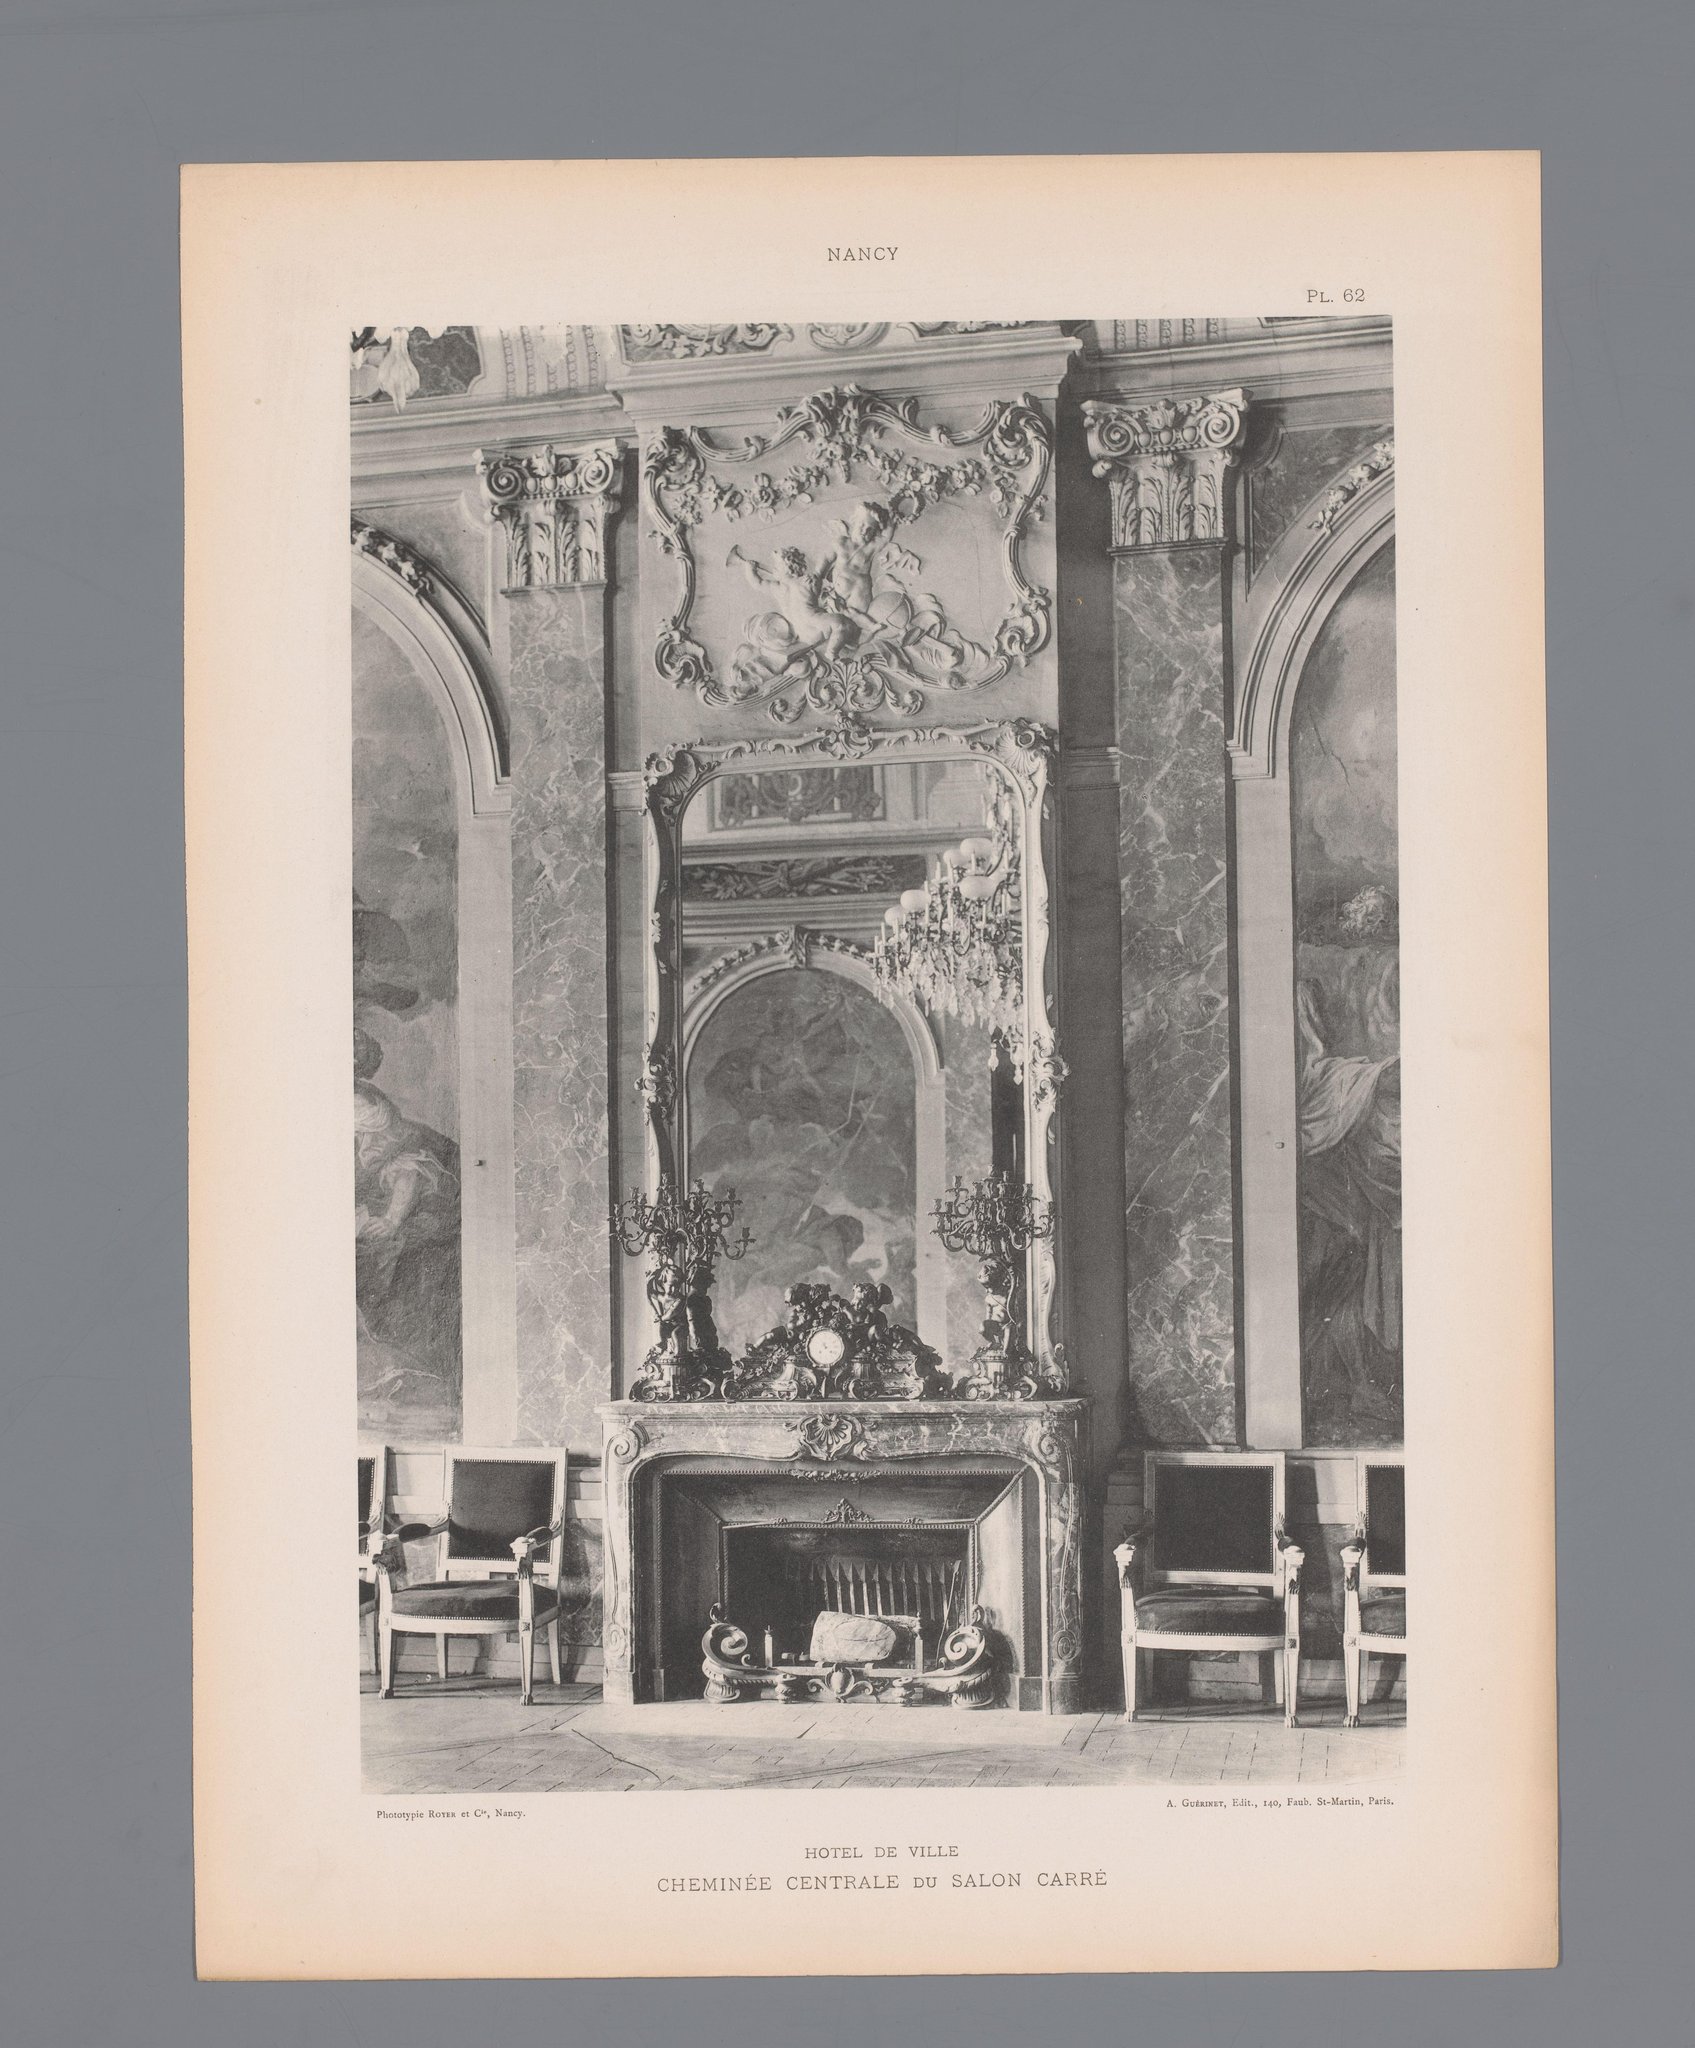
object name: photomechanical print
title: Schoorsteen in het stadhuis te Nancy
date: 1891-1896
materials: paper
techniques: photograph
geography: paris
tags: townhall, chimney-piece, mantelpiece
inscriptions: inscription: ‘Hotel de ville/ Cheminée centrale du salon carré’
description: Deze prent maakt deel uit van een omslag met 103 prenten op 101 bladen en een titelblad.